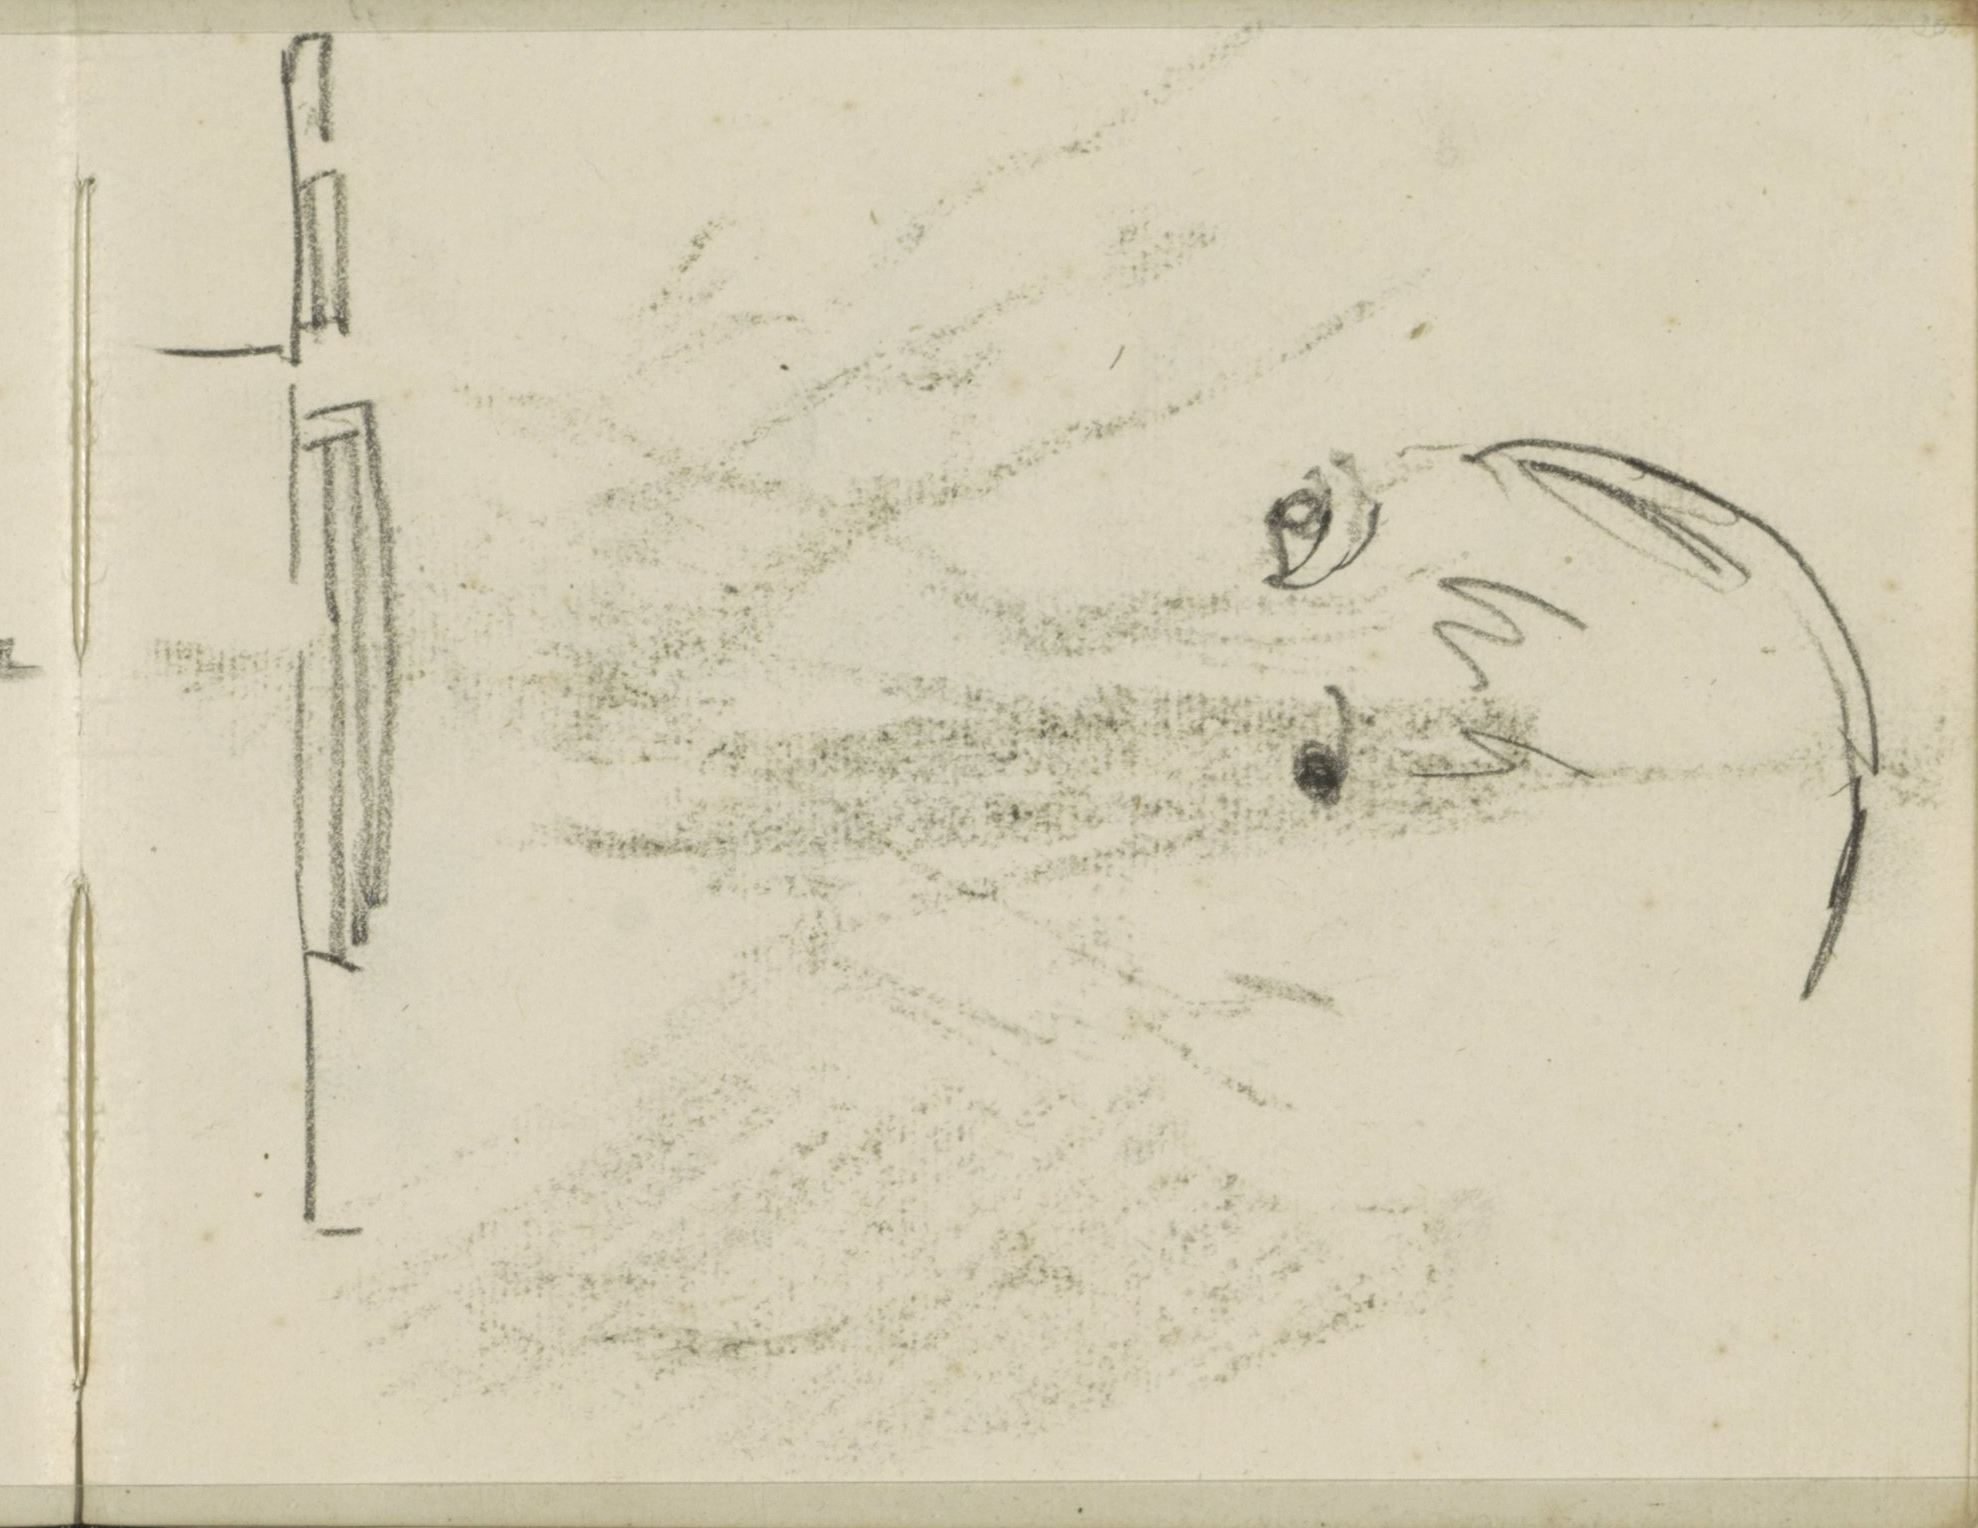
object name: sketchbook leaf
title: Hoofd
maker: george hendrik breitner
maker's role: draughtsman, painter, print maker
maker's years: 1857-1923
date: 1886-1903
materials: chalk, paper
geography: amsterdam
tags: head (human)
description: Pagina 30 uit een schetsboek met 27 bladen.